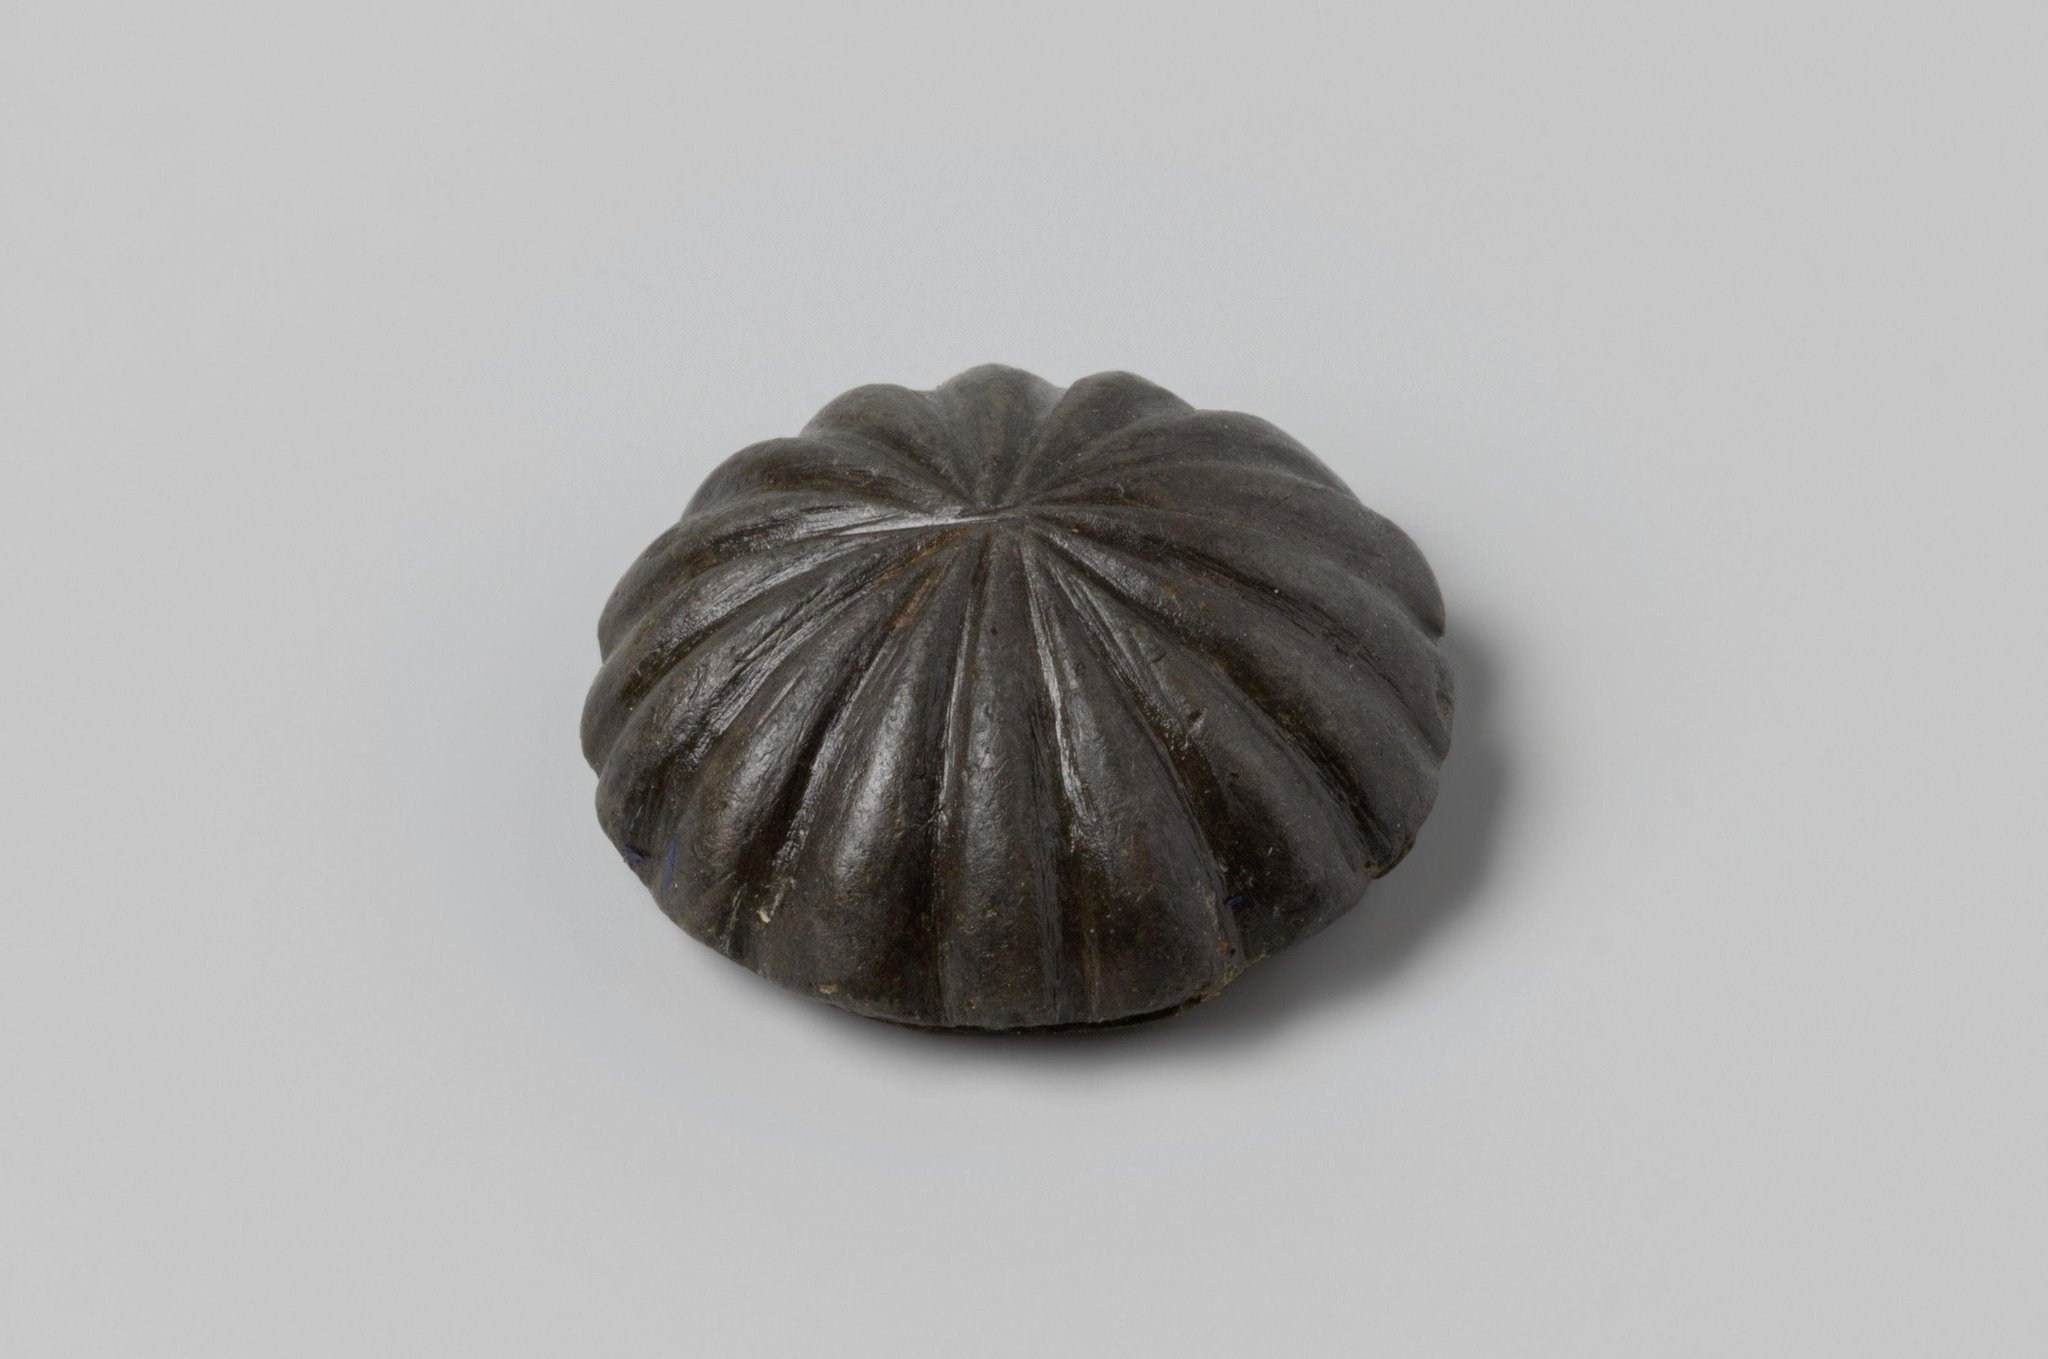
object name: button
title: Knoop uit het wrak van de Oost-Indiëvaarder Hollandia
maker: Anonymous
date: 1700-1743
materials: copper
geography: netherlands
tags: verenigde oostindische compagnie, hollandia (schip), annet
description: Knoop. (1) domed top, radially fluted (2.1d, 0.8t), applied flat base, shank missing